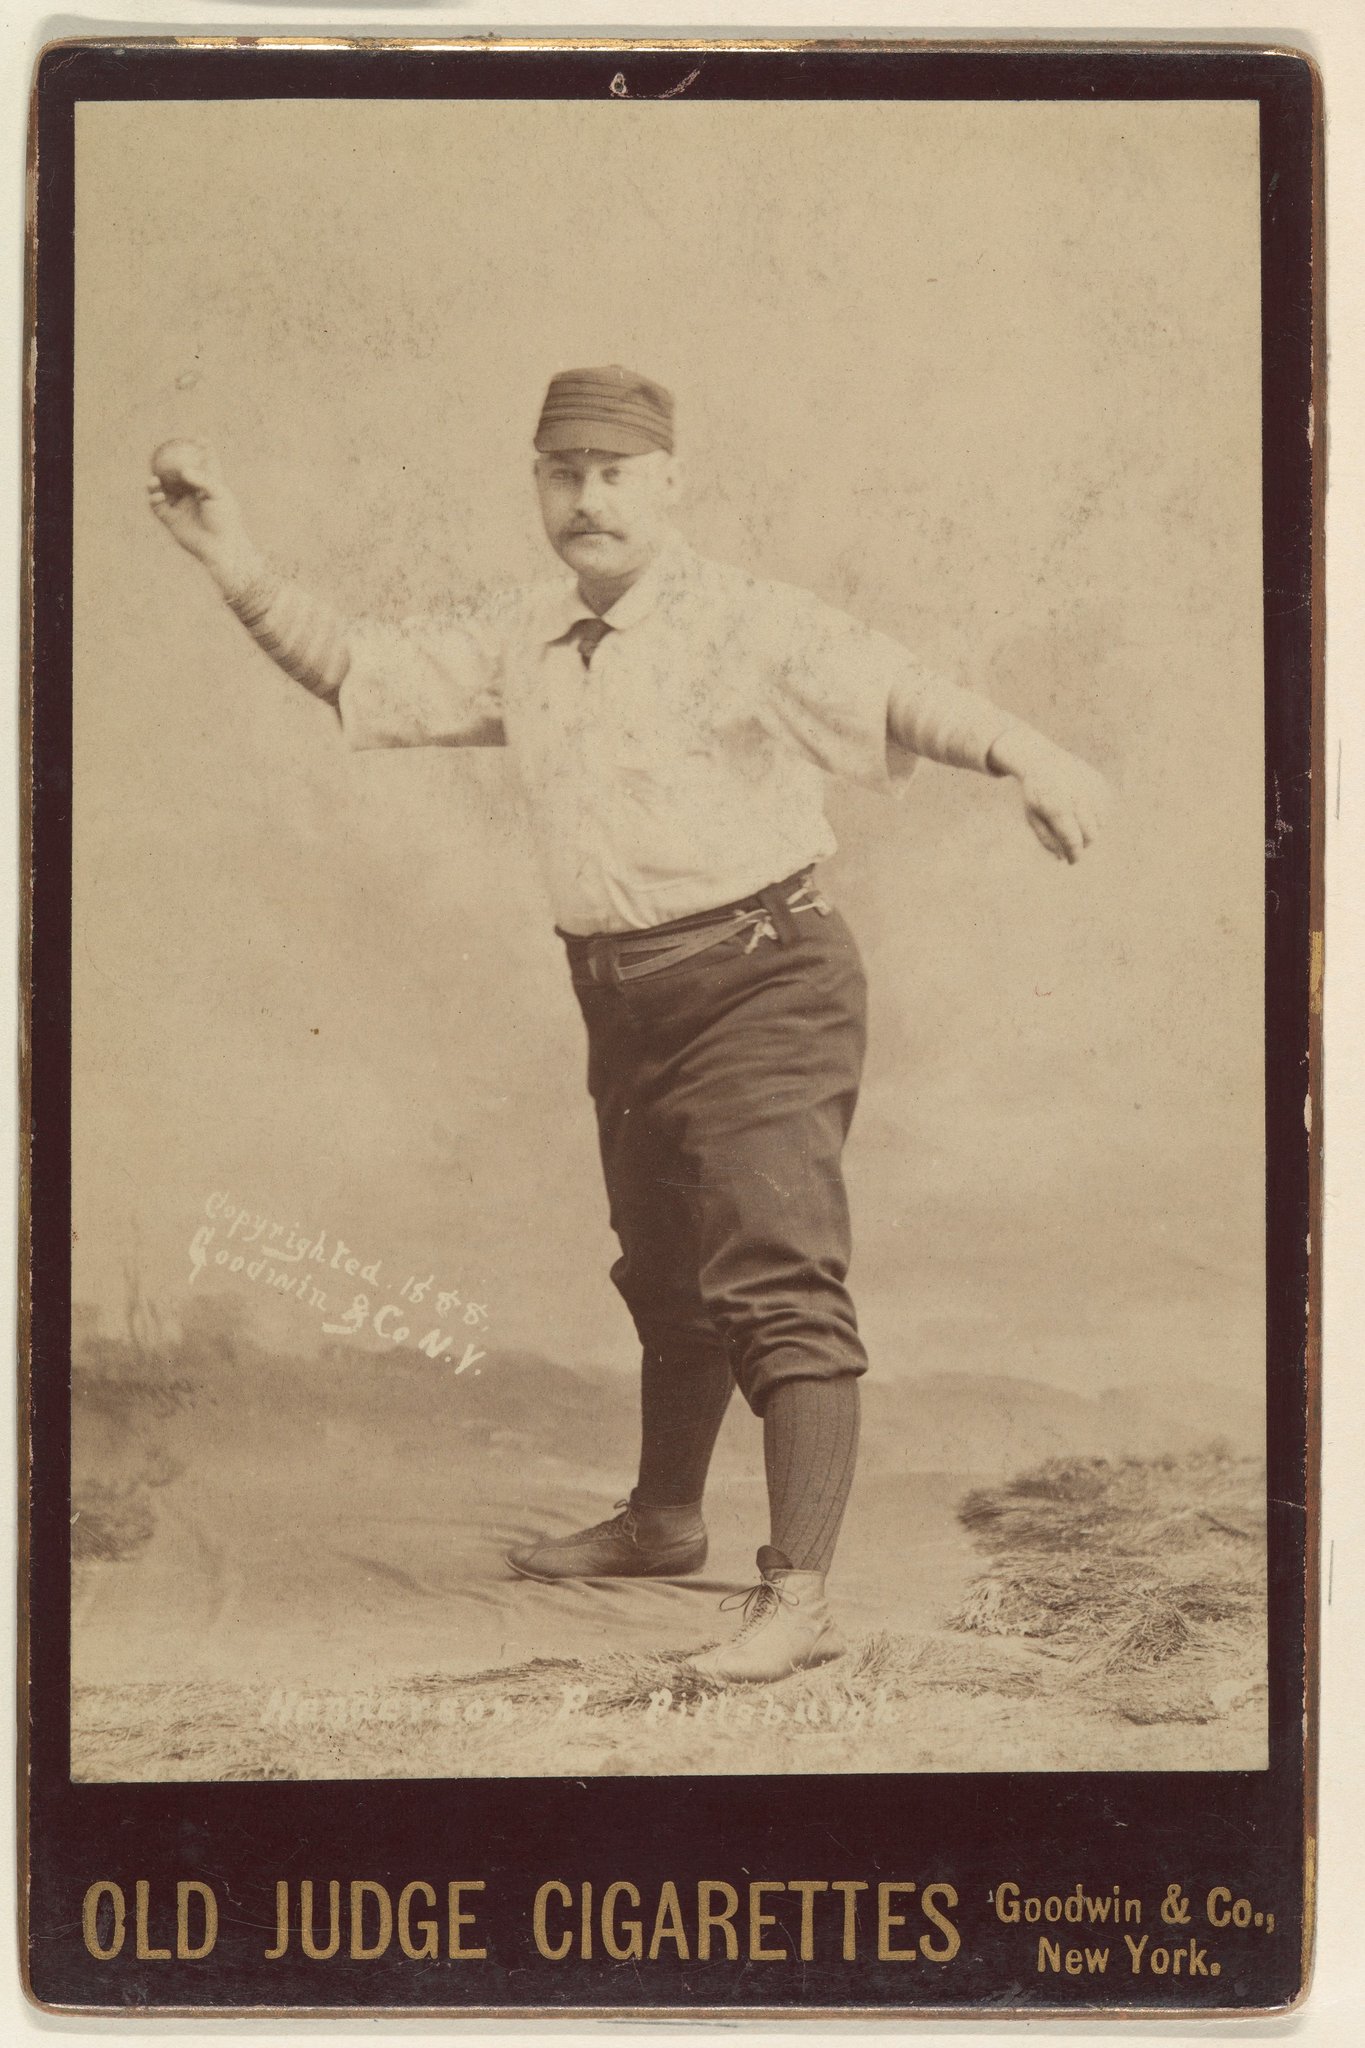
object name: baseball card, photograph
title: Henderson, Pitcher, Pittsburgh, from the series Old Judge Cigarettes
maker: goodwin & company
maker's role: publisher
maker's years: 1850-1950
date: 1888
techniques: albumen print, photography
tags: men,portraits,baseball,athletes